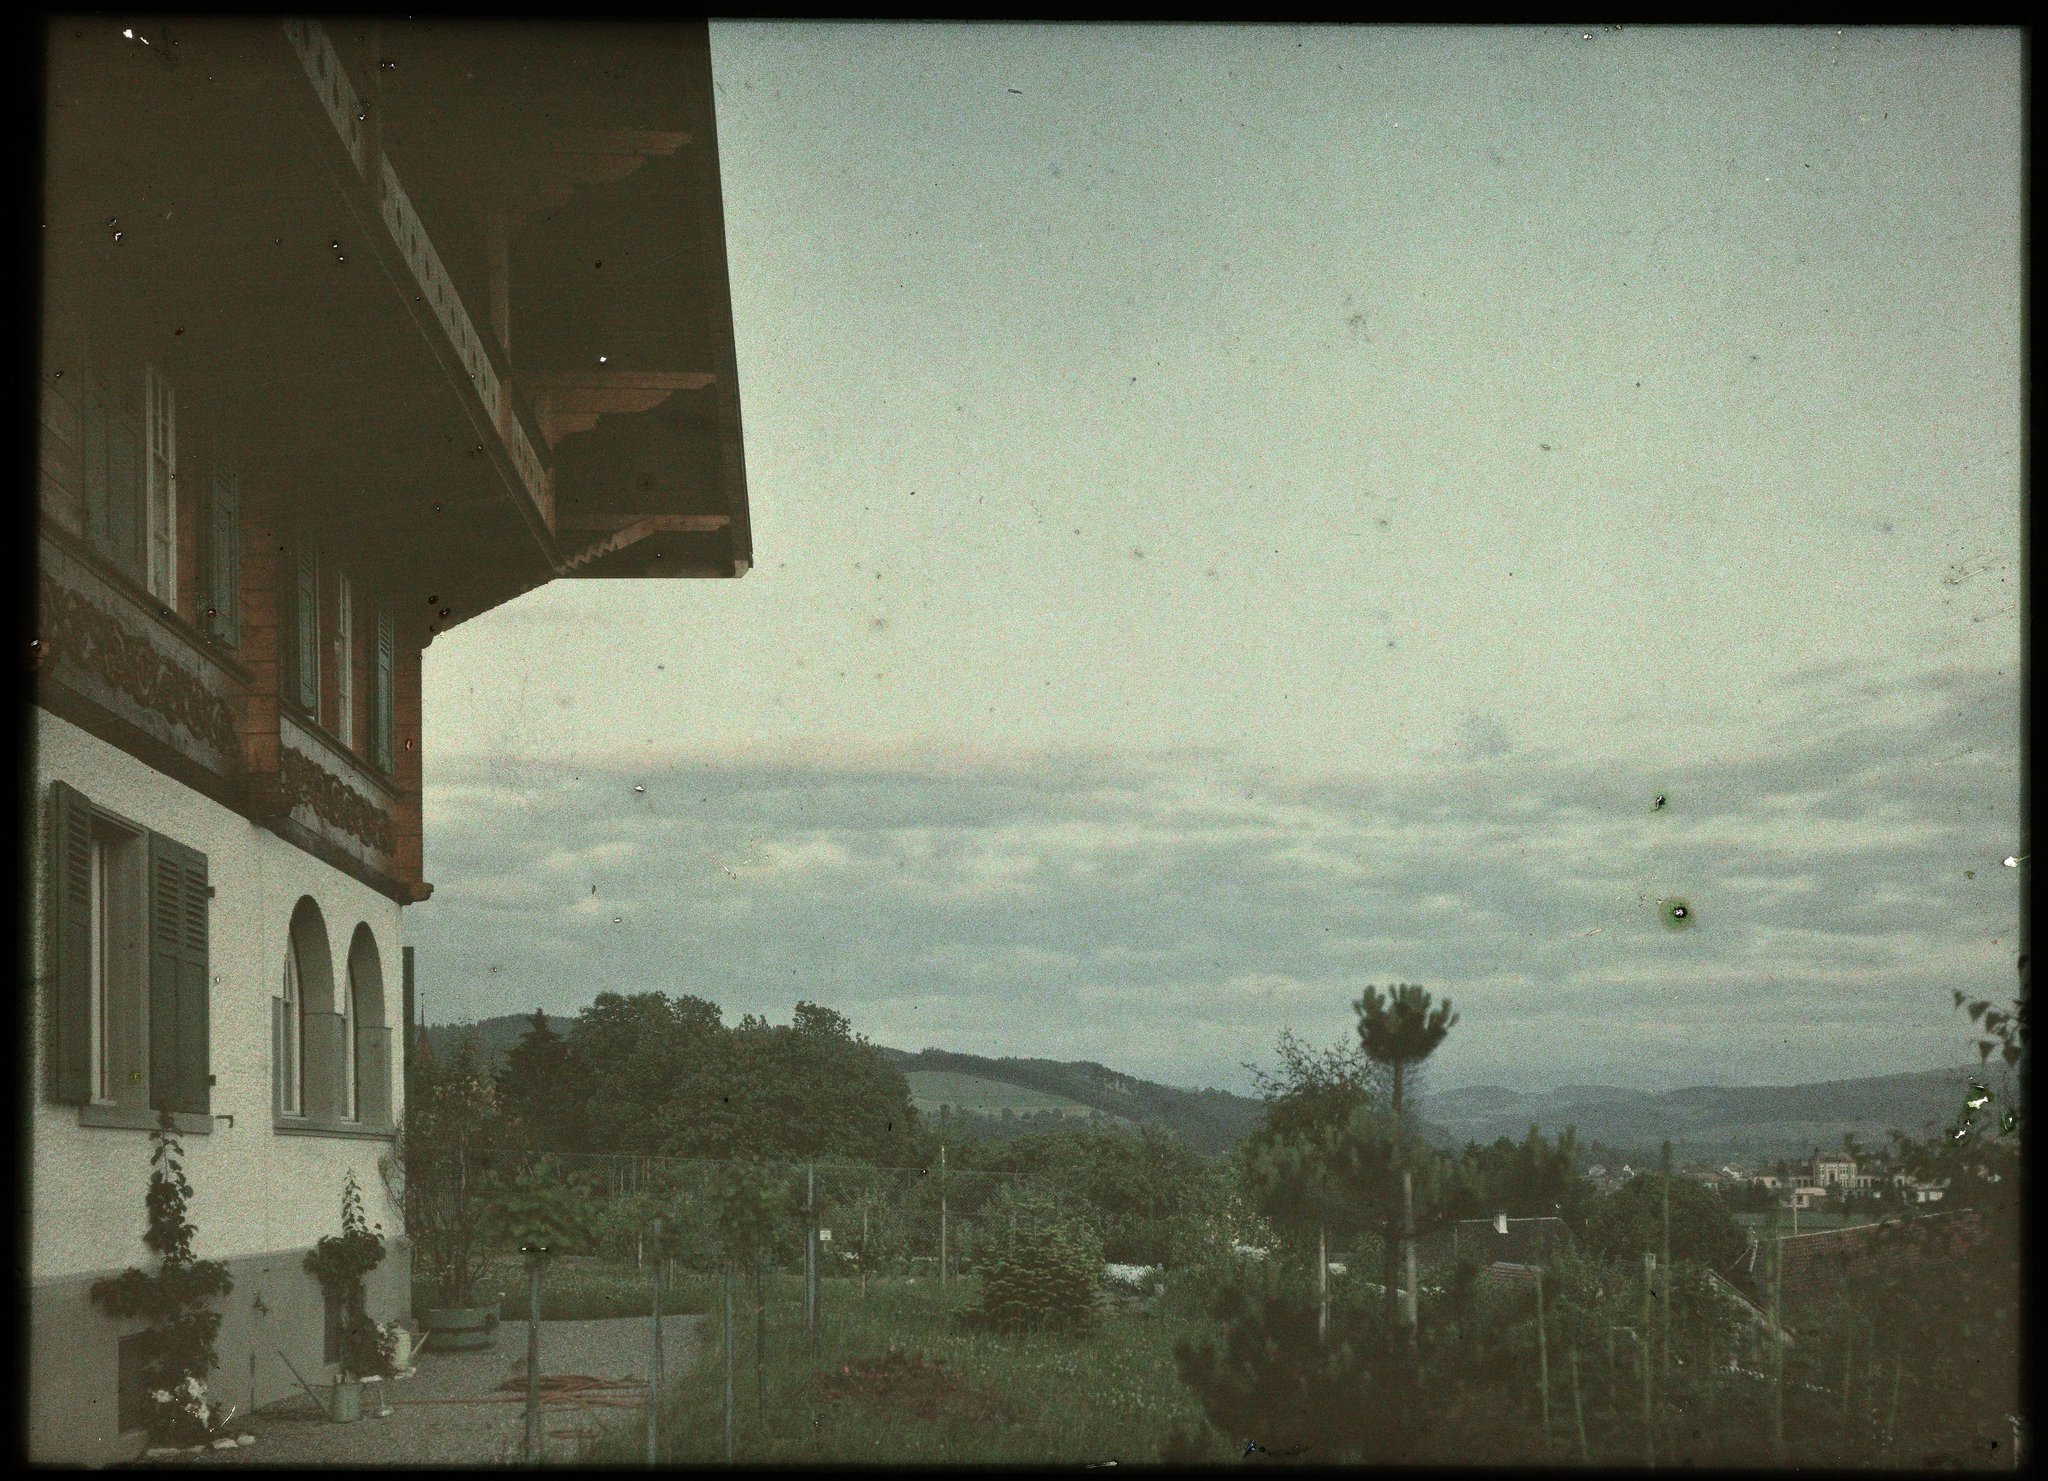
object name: color slide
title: Landschap met chalet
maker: adolphe burdet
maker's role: fotograaf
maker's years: 1860-1940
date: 1907-1930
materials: glass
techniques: autochrome process, slide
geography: switzerland